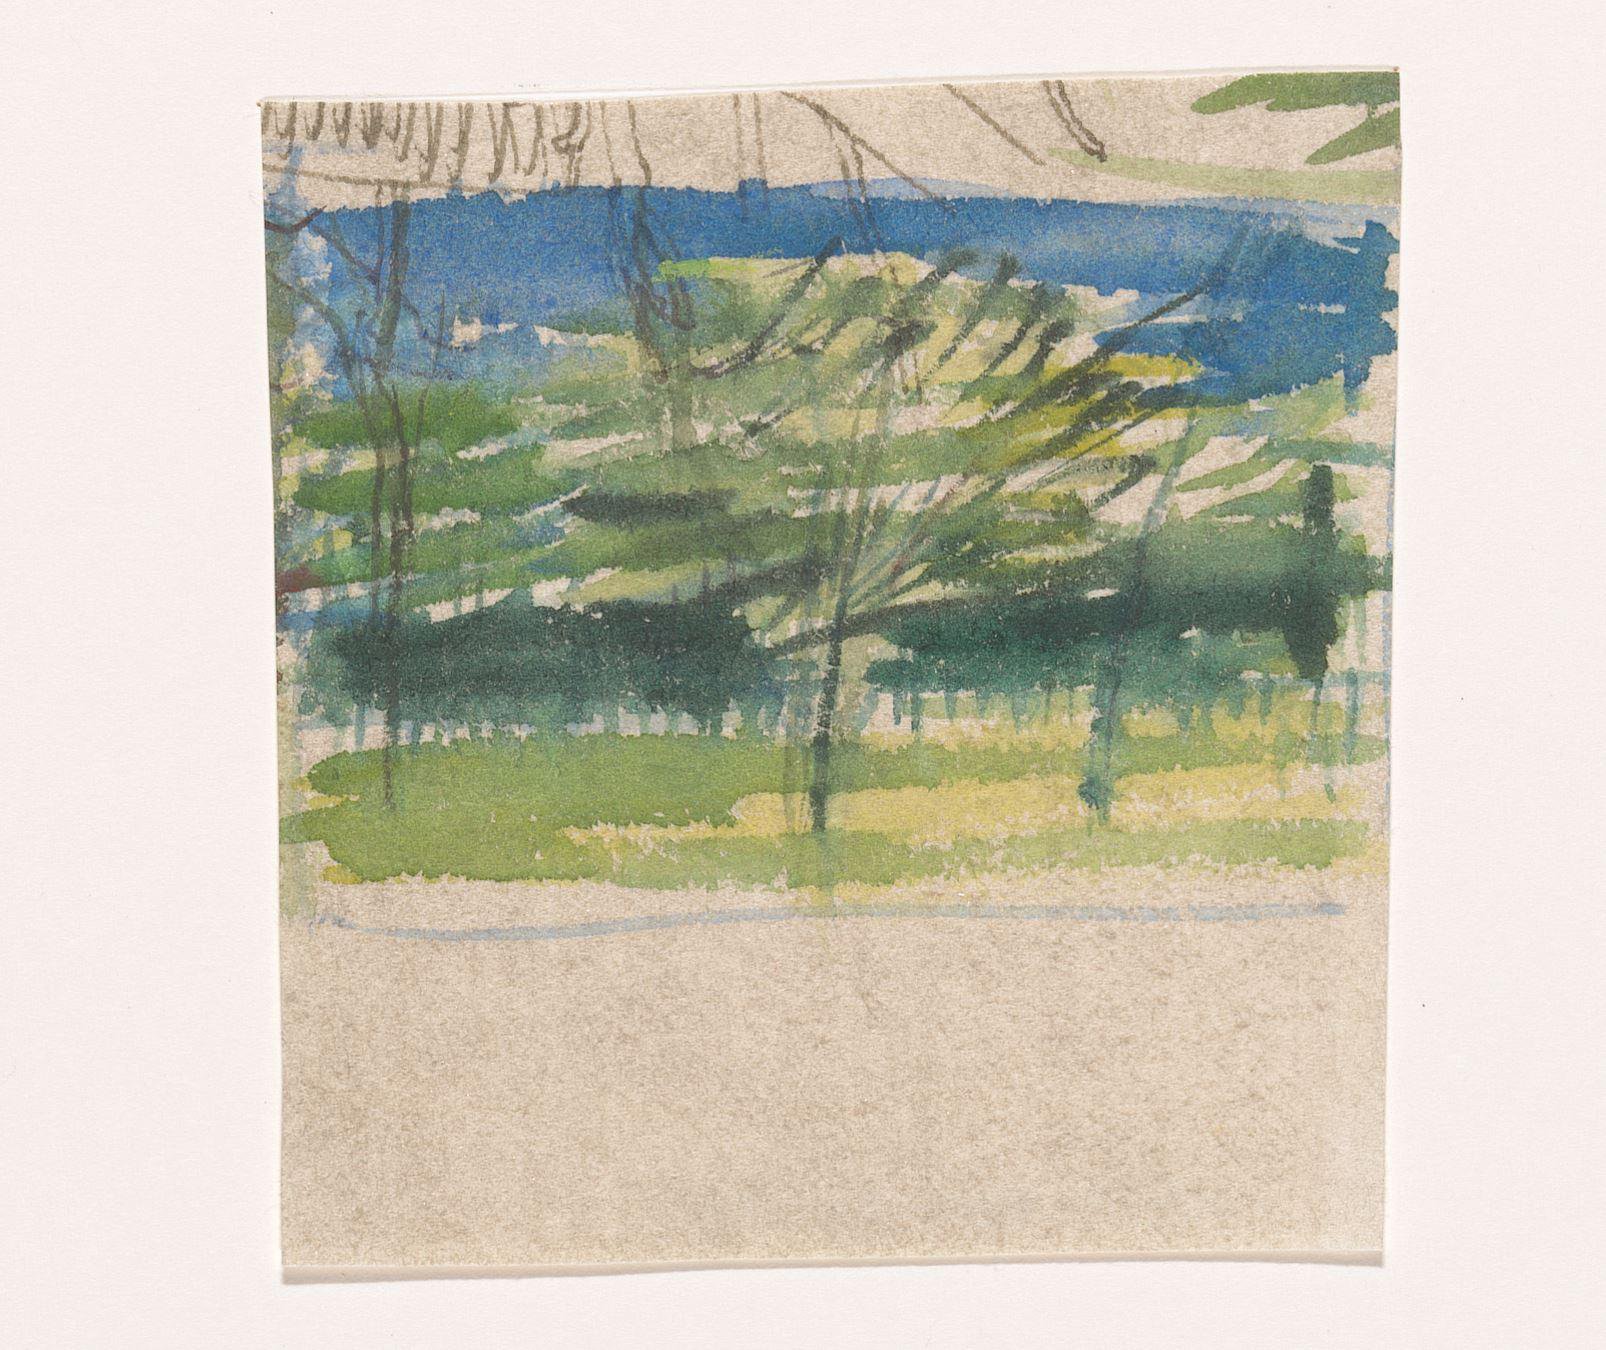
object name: drawing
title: Bomen in blad tegen blauwe lucht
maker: kees stoop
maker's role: draughtsman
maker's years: 1929-2019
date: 1939-2009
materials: paper, watercolor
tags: groups of trees